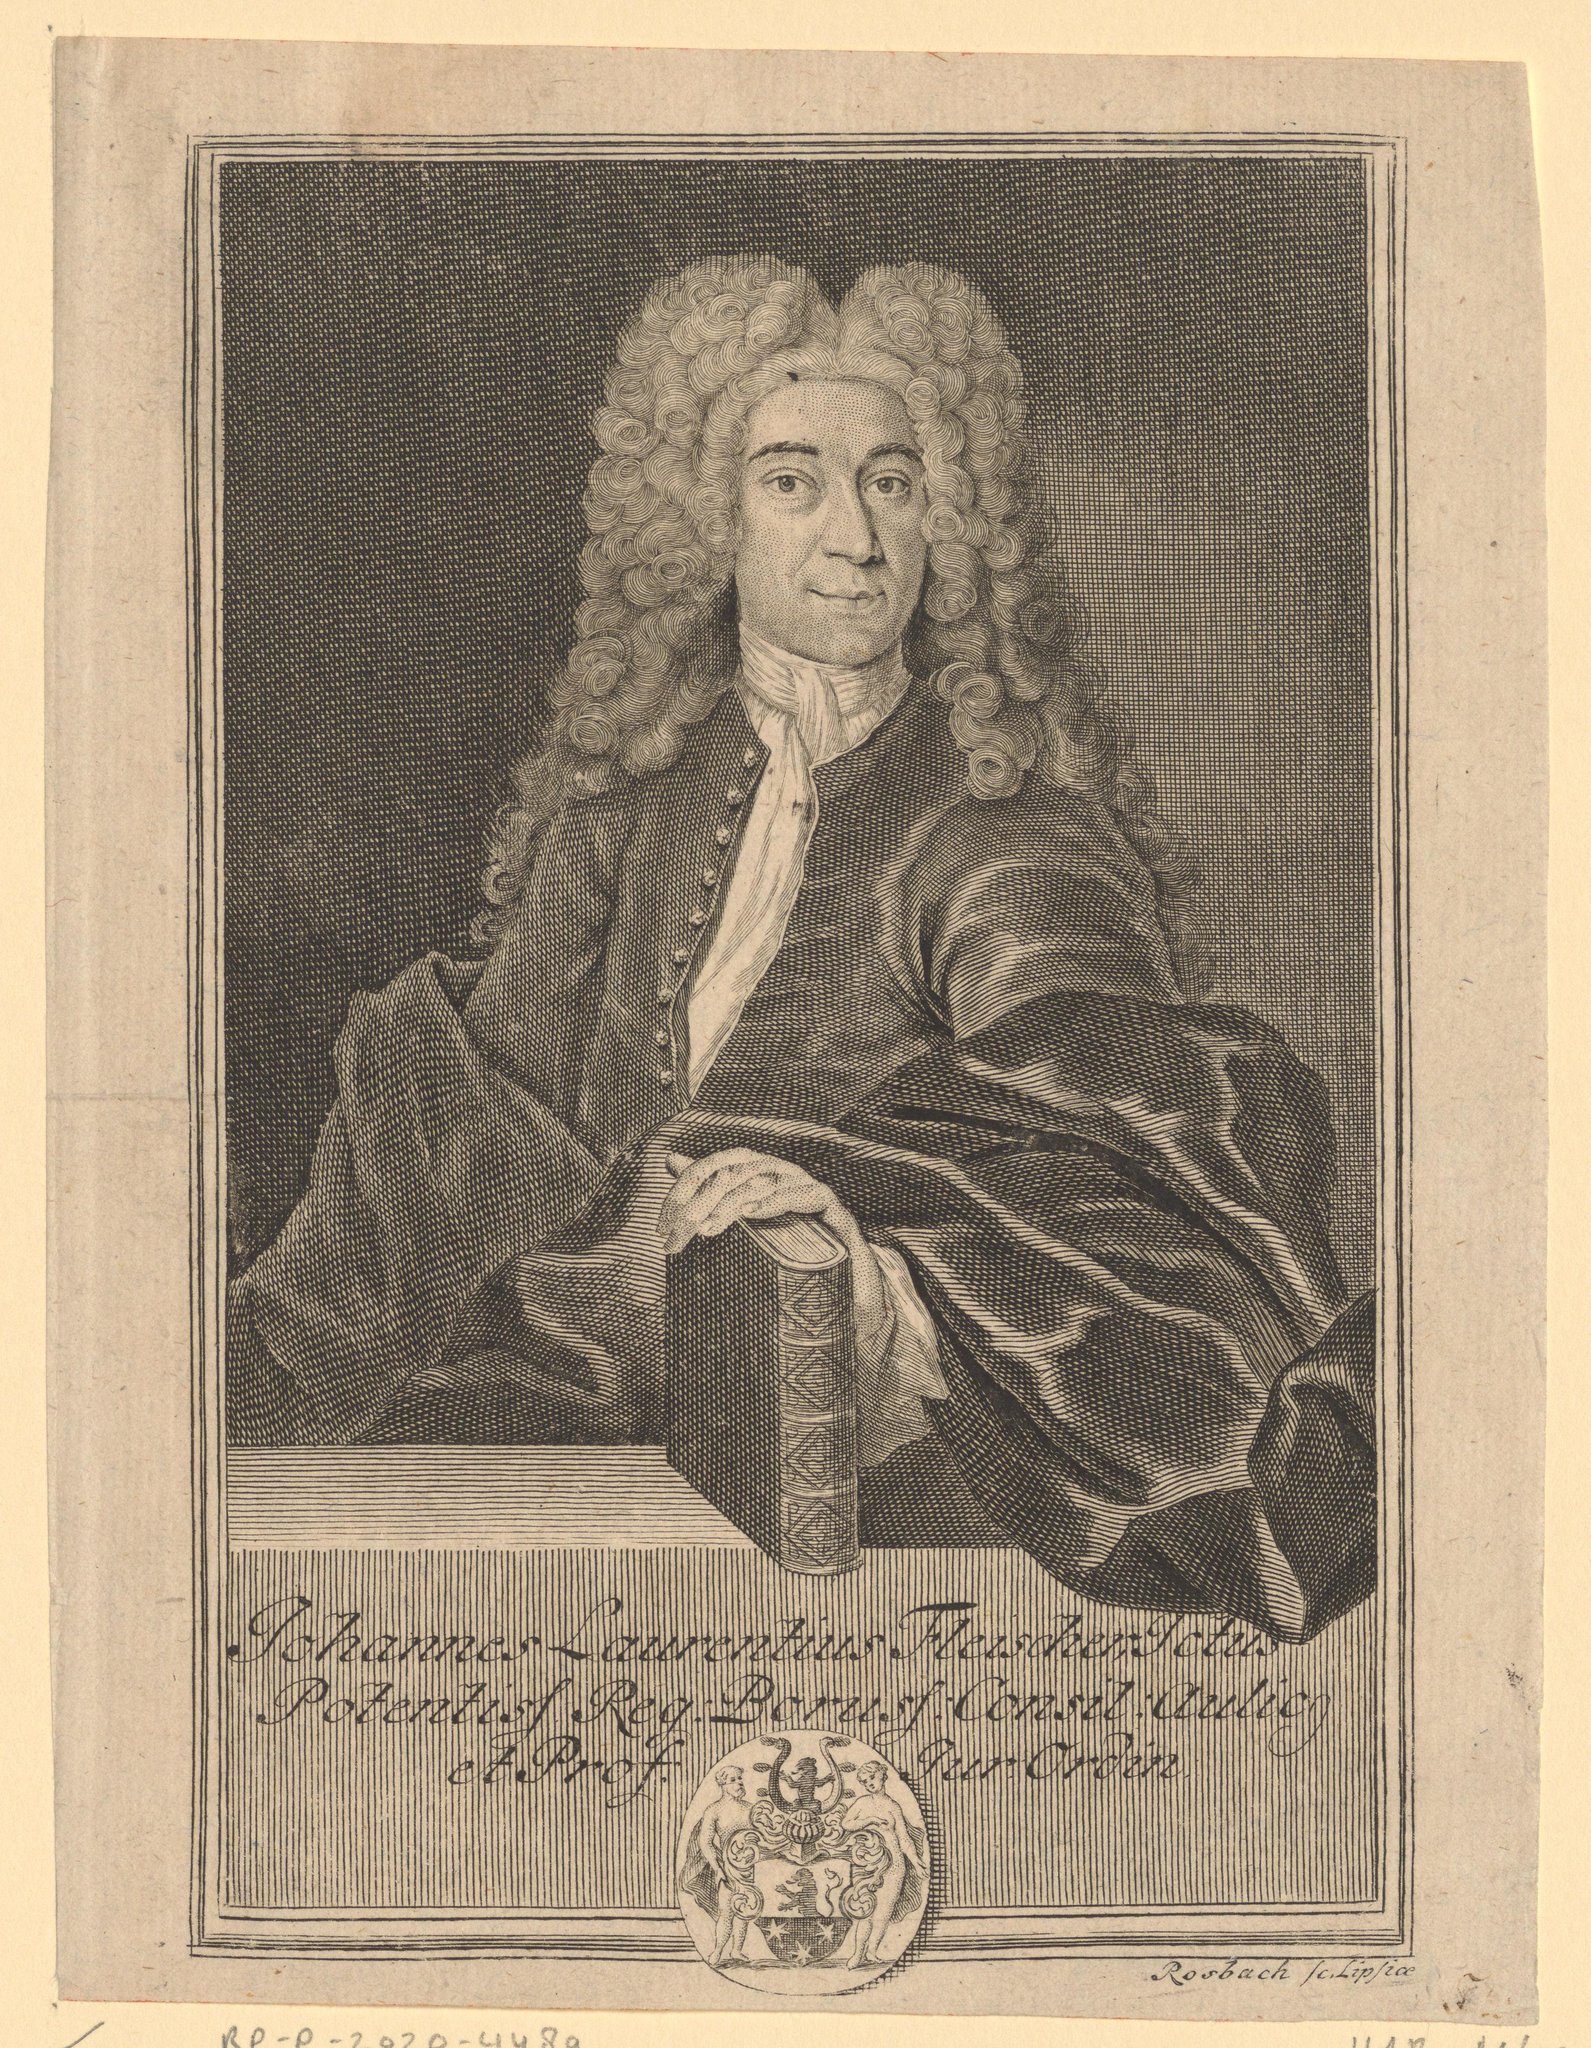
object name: print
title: Portret van Johann Lorenz Fleischer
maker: johann friedrich rosbach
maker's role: print maker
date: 1717-1750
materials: paper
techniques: engraving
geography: leipzig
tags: historical persons, book, professor, armorial bearing, heraldry